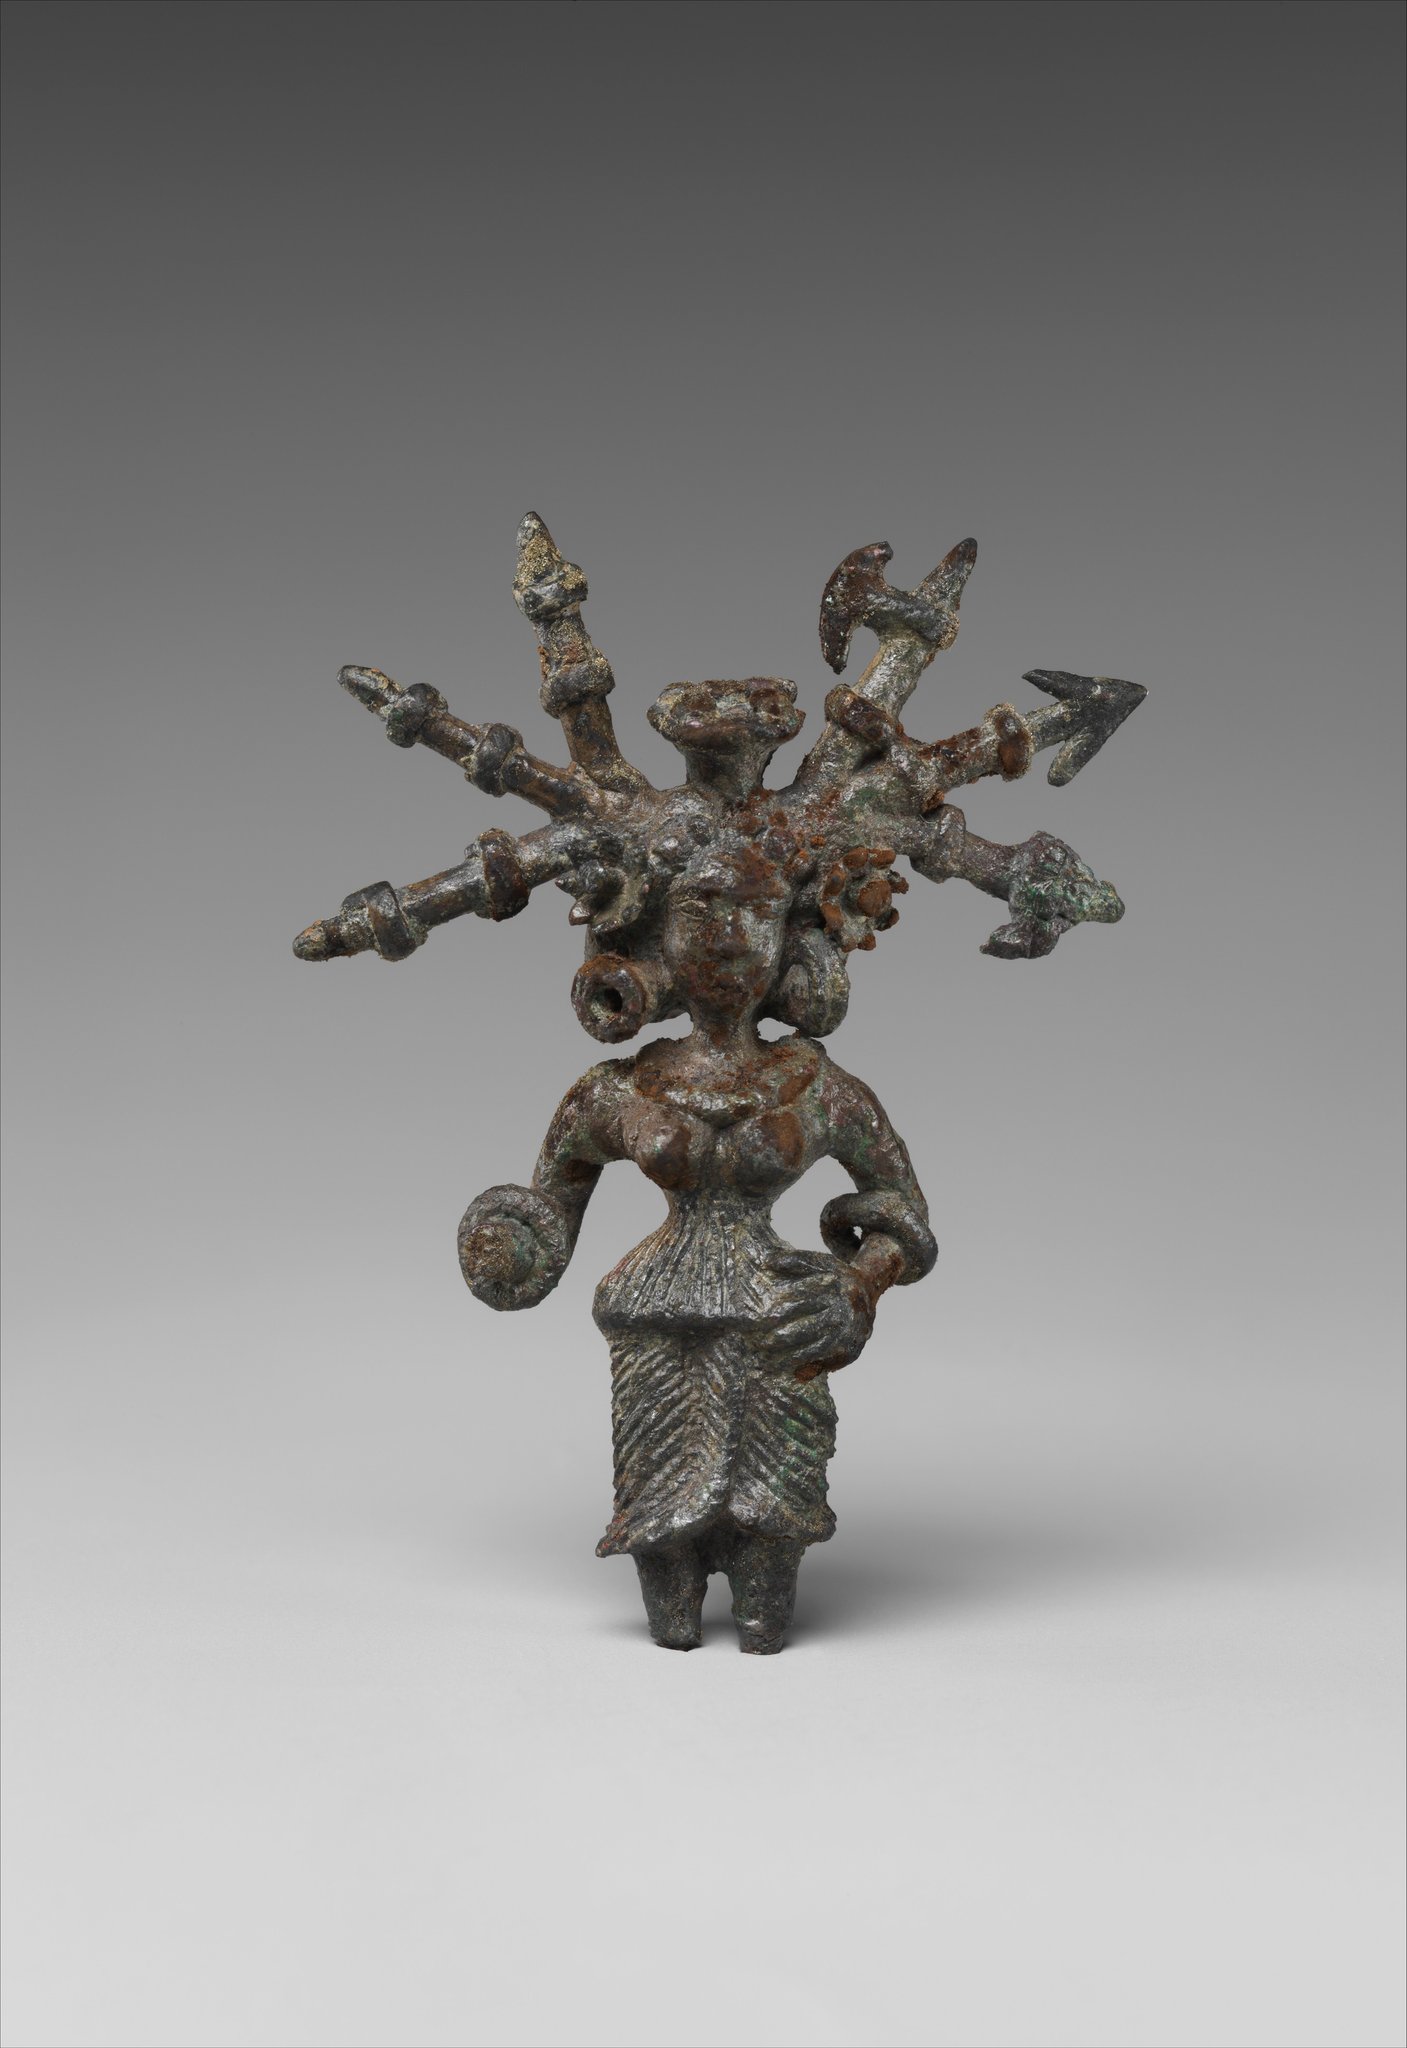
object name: figure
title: Goddess with Weapons in Her Hair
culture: indian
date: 200-101 BCE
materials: copper alloy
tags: weapons,hair,goddess